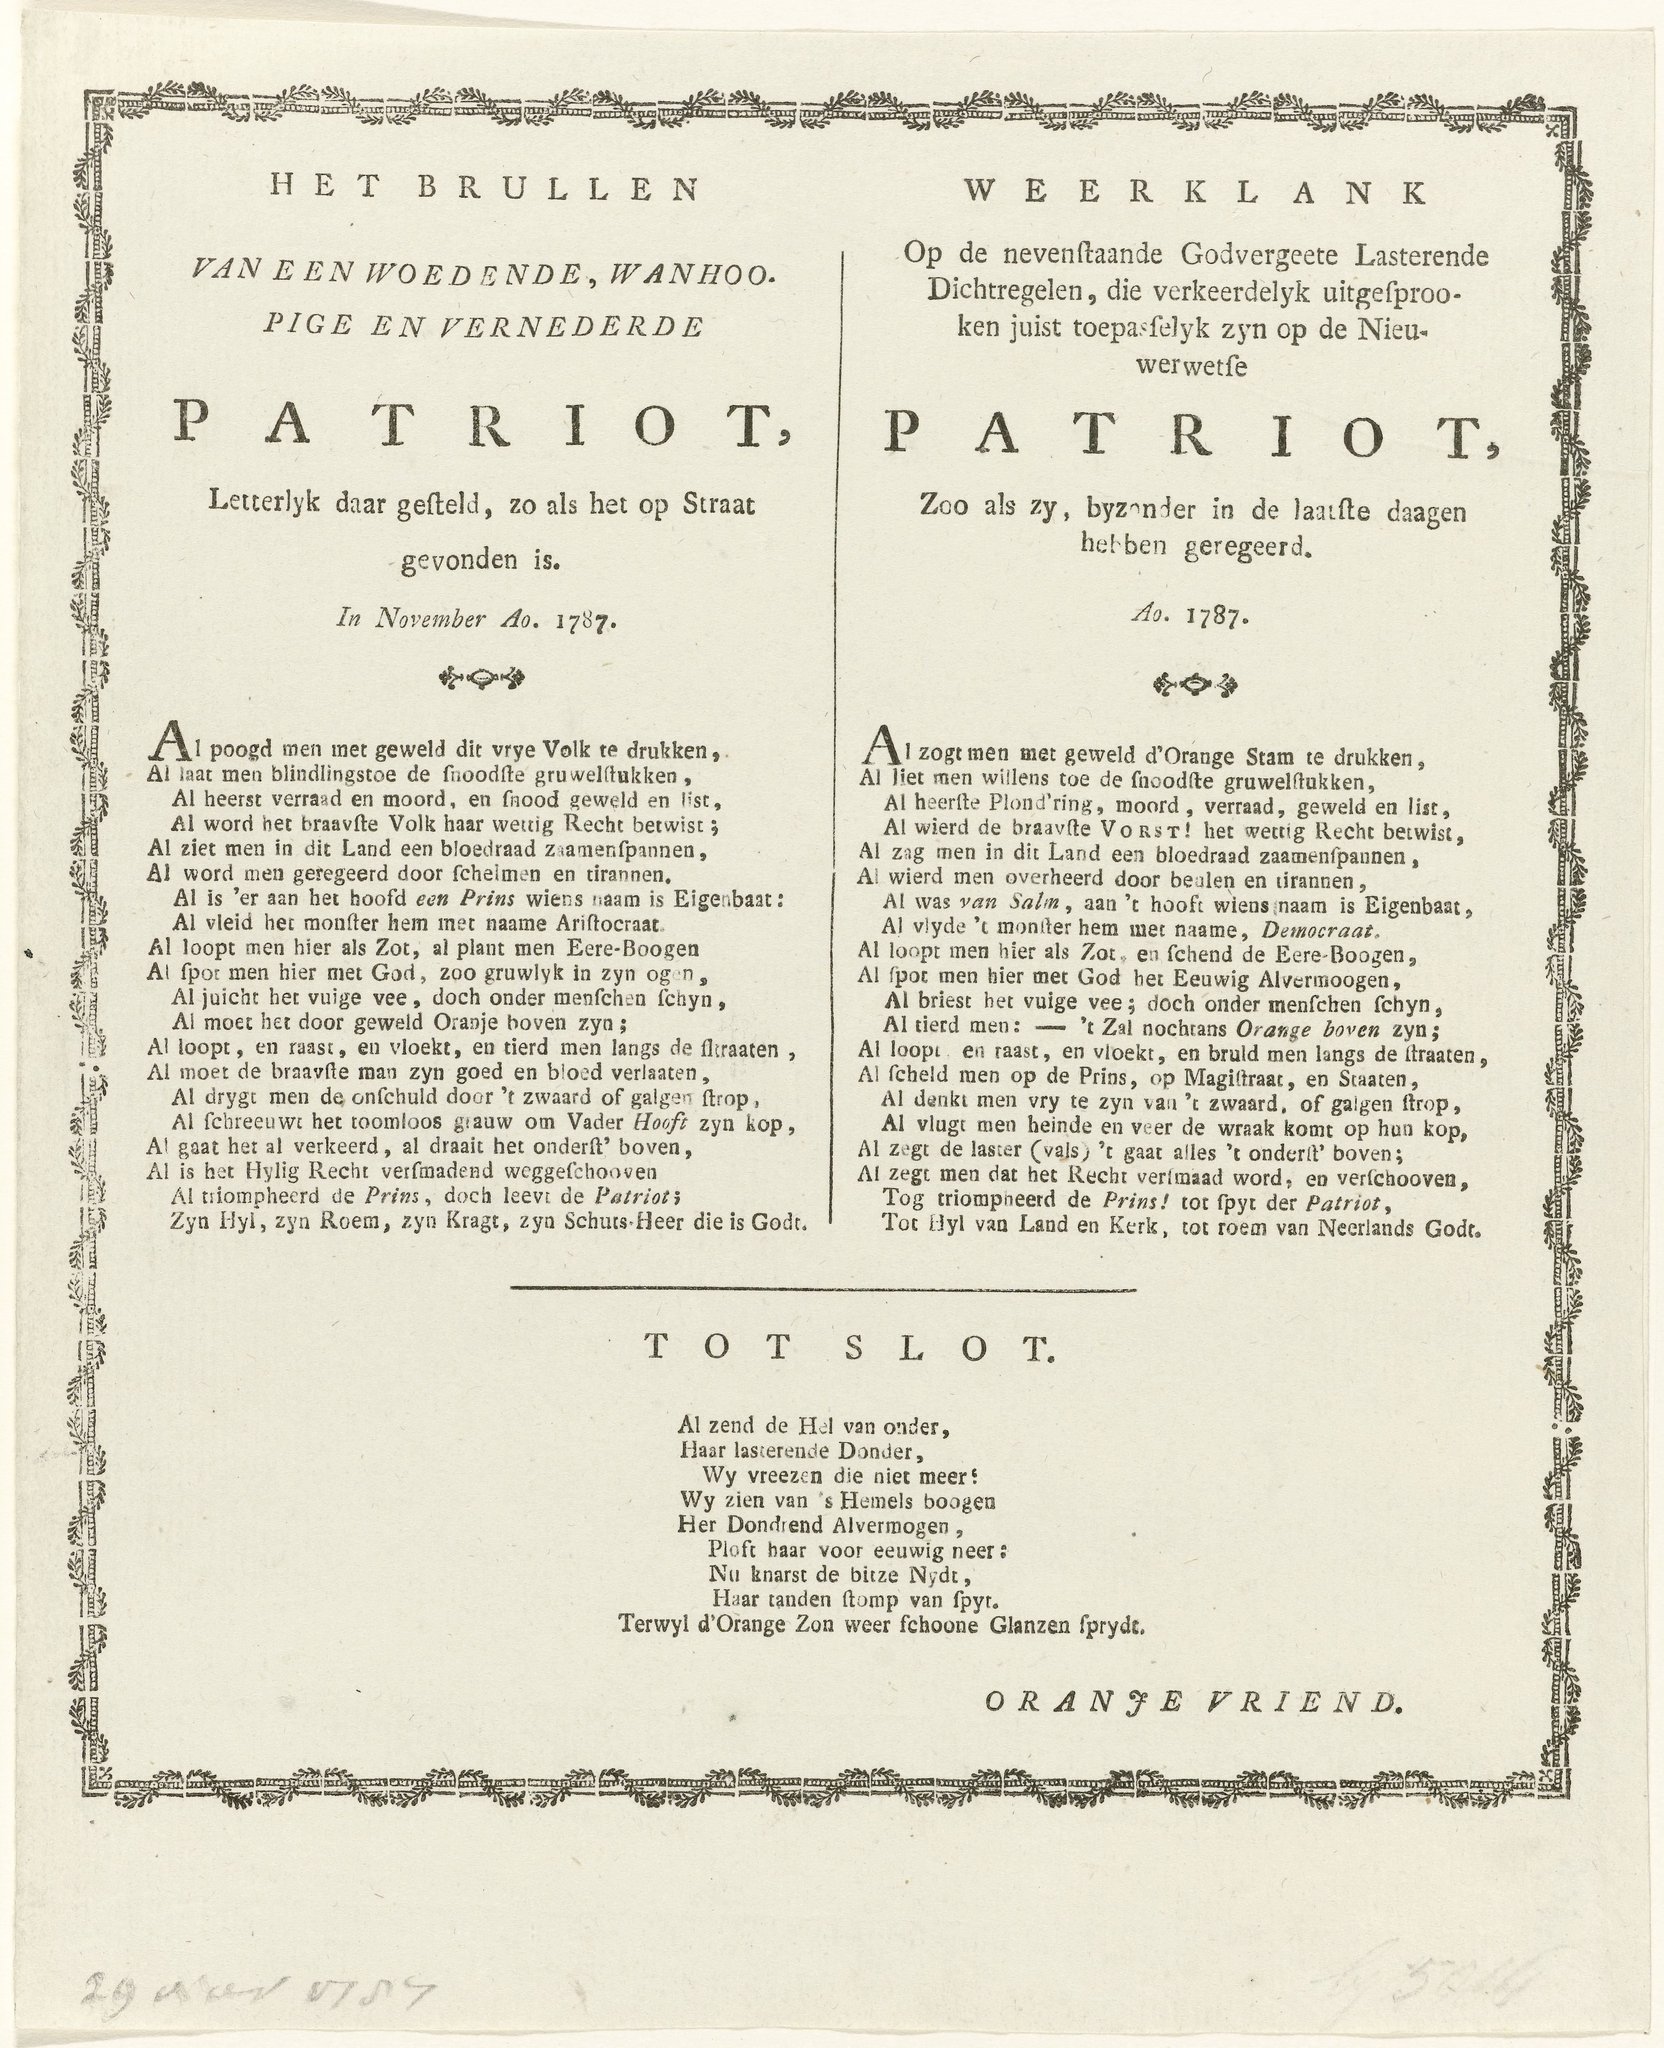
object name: text sheet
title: Het brullen van een woedende, wanhoopige en vernederde Patriot (...) November Ao. 1787 / Weerklank op de nevenstaande Godvergeete Lasterende Dichtregelen (...)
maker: Anonymous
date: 1787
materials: paper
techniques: letterpress printing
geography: northern netherlands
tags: herstel van stadhouder willem v (1787)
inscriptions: collector's mark: Lugt 2228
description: Blad met een spotvers op de val van de patriotten na het herstel van de prins van Oranje in 1787. Links de klacht van de vernederde patriot, rechts het oranjegezinde antwoord in de vorm van een weerklank.